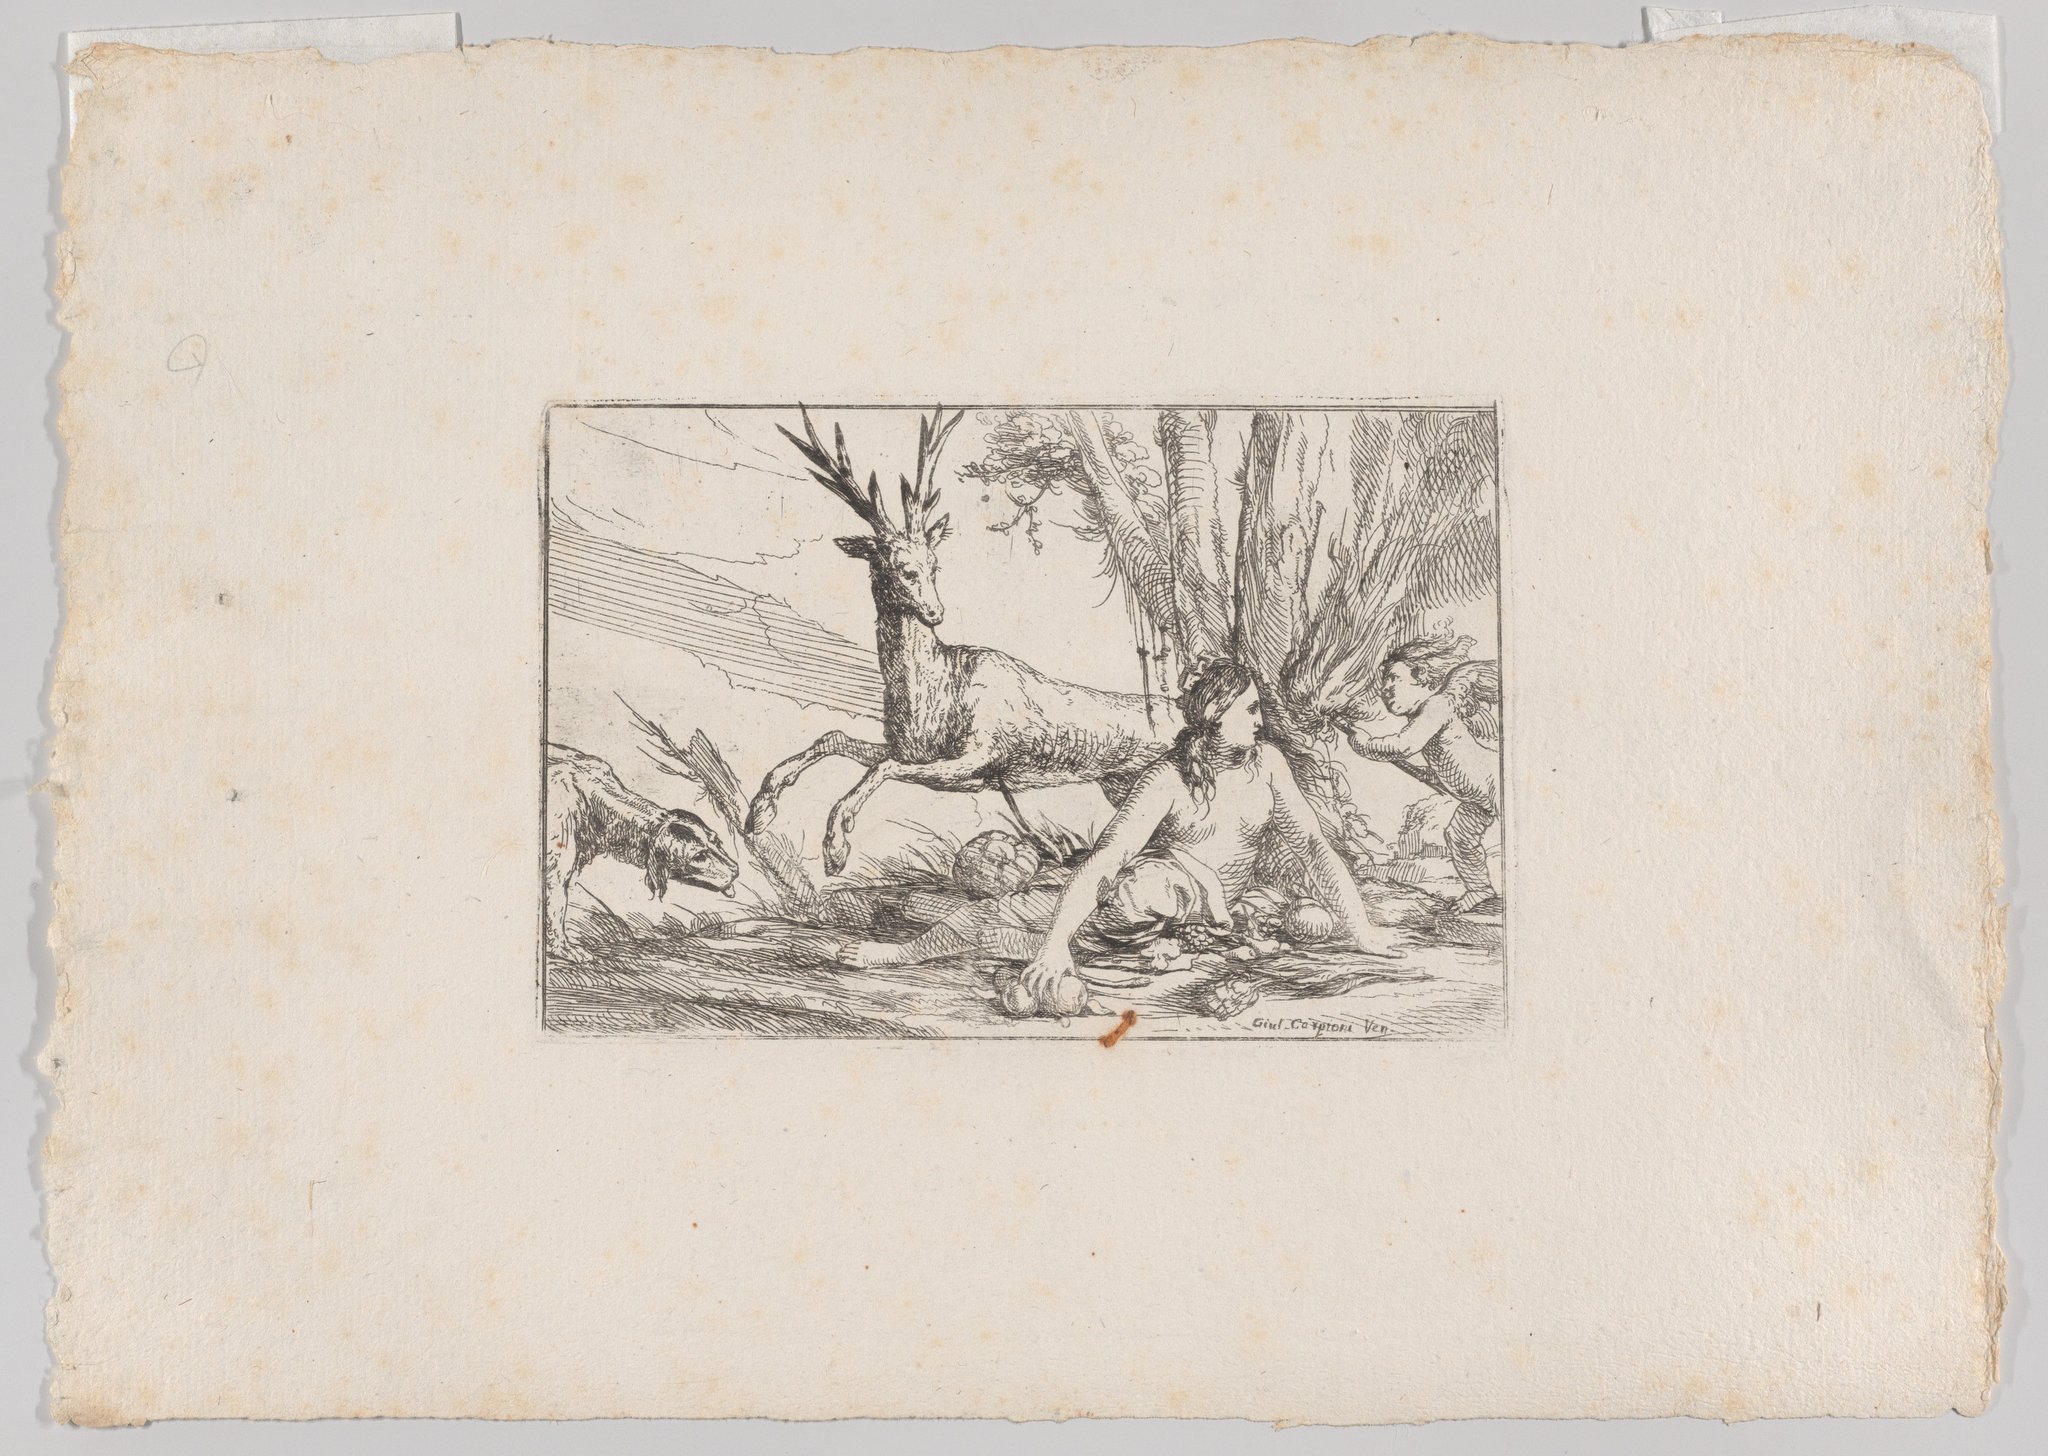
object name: print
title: Earth, represented by Cybele seated at the base of a tree with fruits of the earth spread before her, a cupid with a torch approaches from the right, a stag and hound look toward Cybele from the left, from "The Elements"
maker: giulio carpioni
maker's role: artist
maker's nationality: italian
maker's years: 1613-1678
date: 1640-1660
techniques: etching